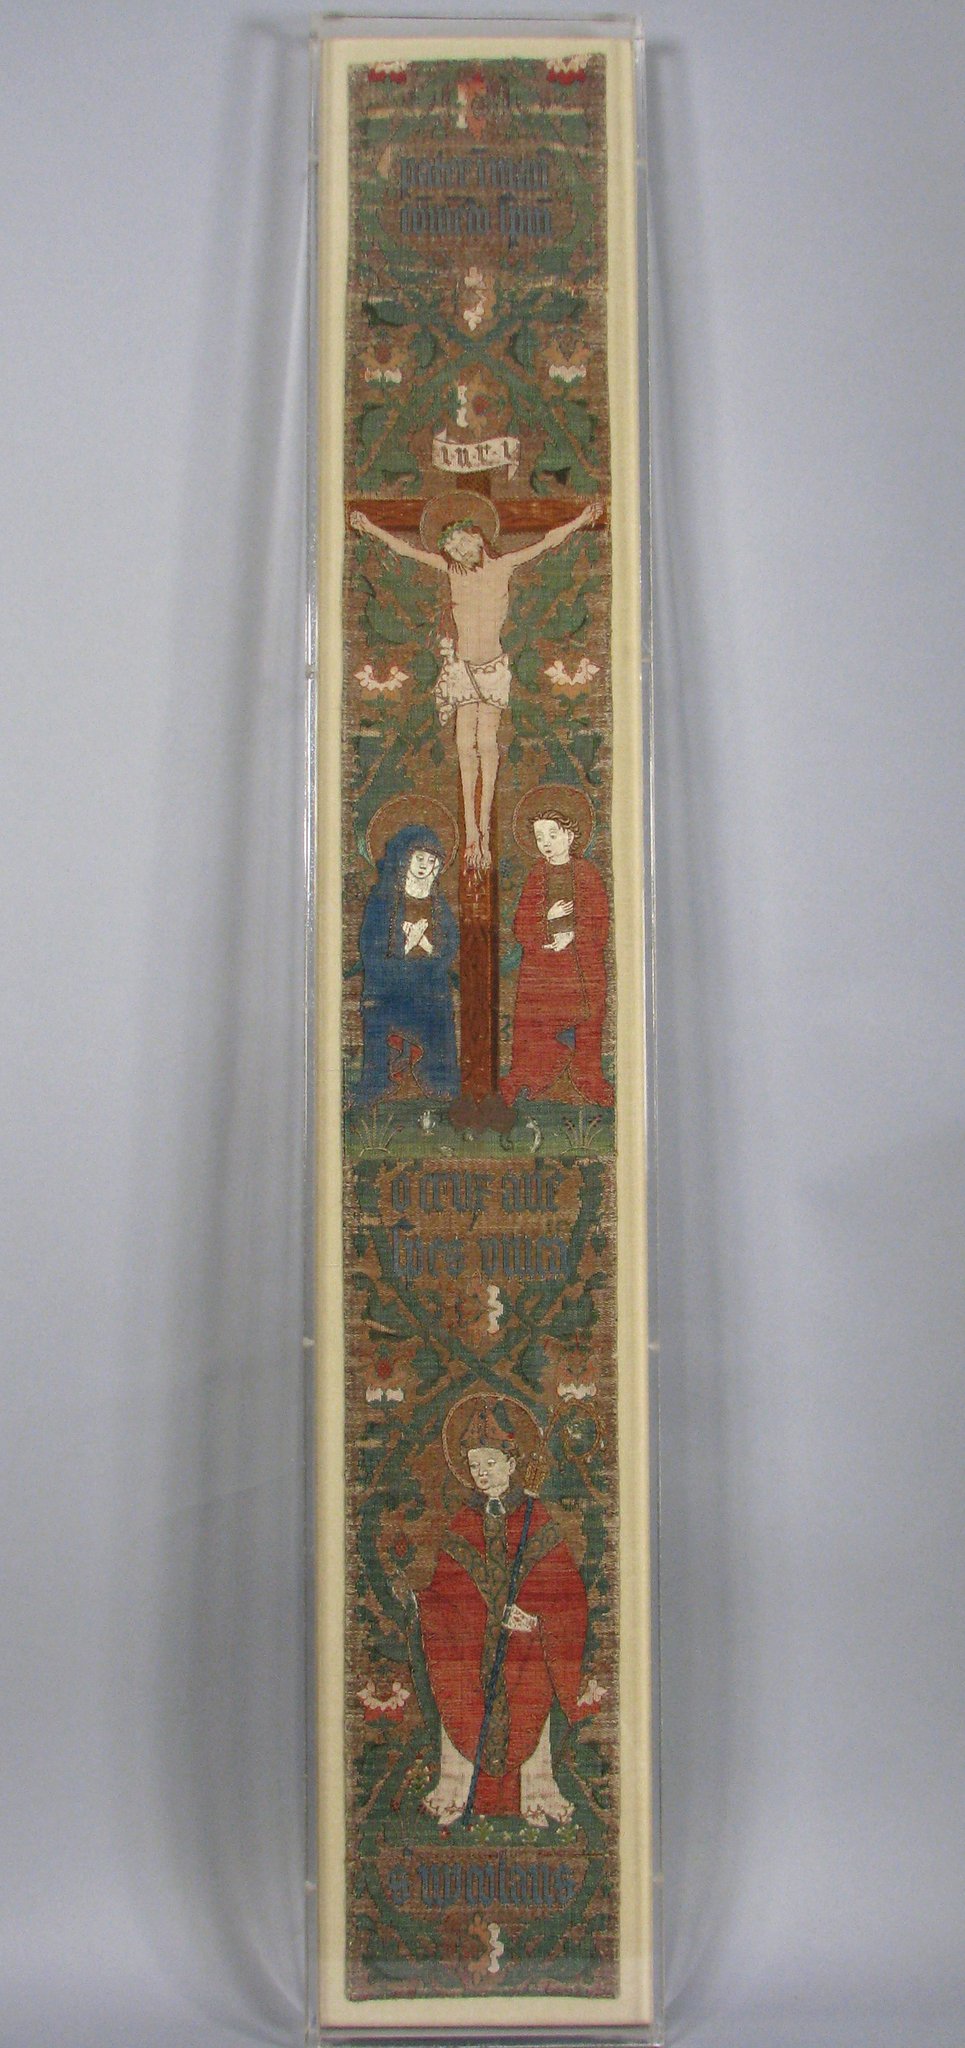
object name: orphrey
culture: german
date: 1401-1500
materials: linen, metal thread, silk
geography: germany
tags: christ,virgin mary,crucifixion,saints